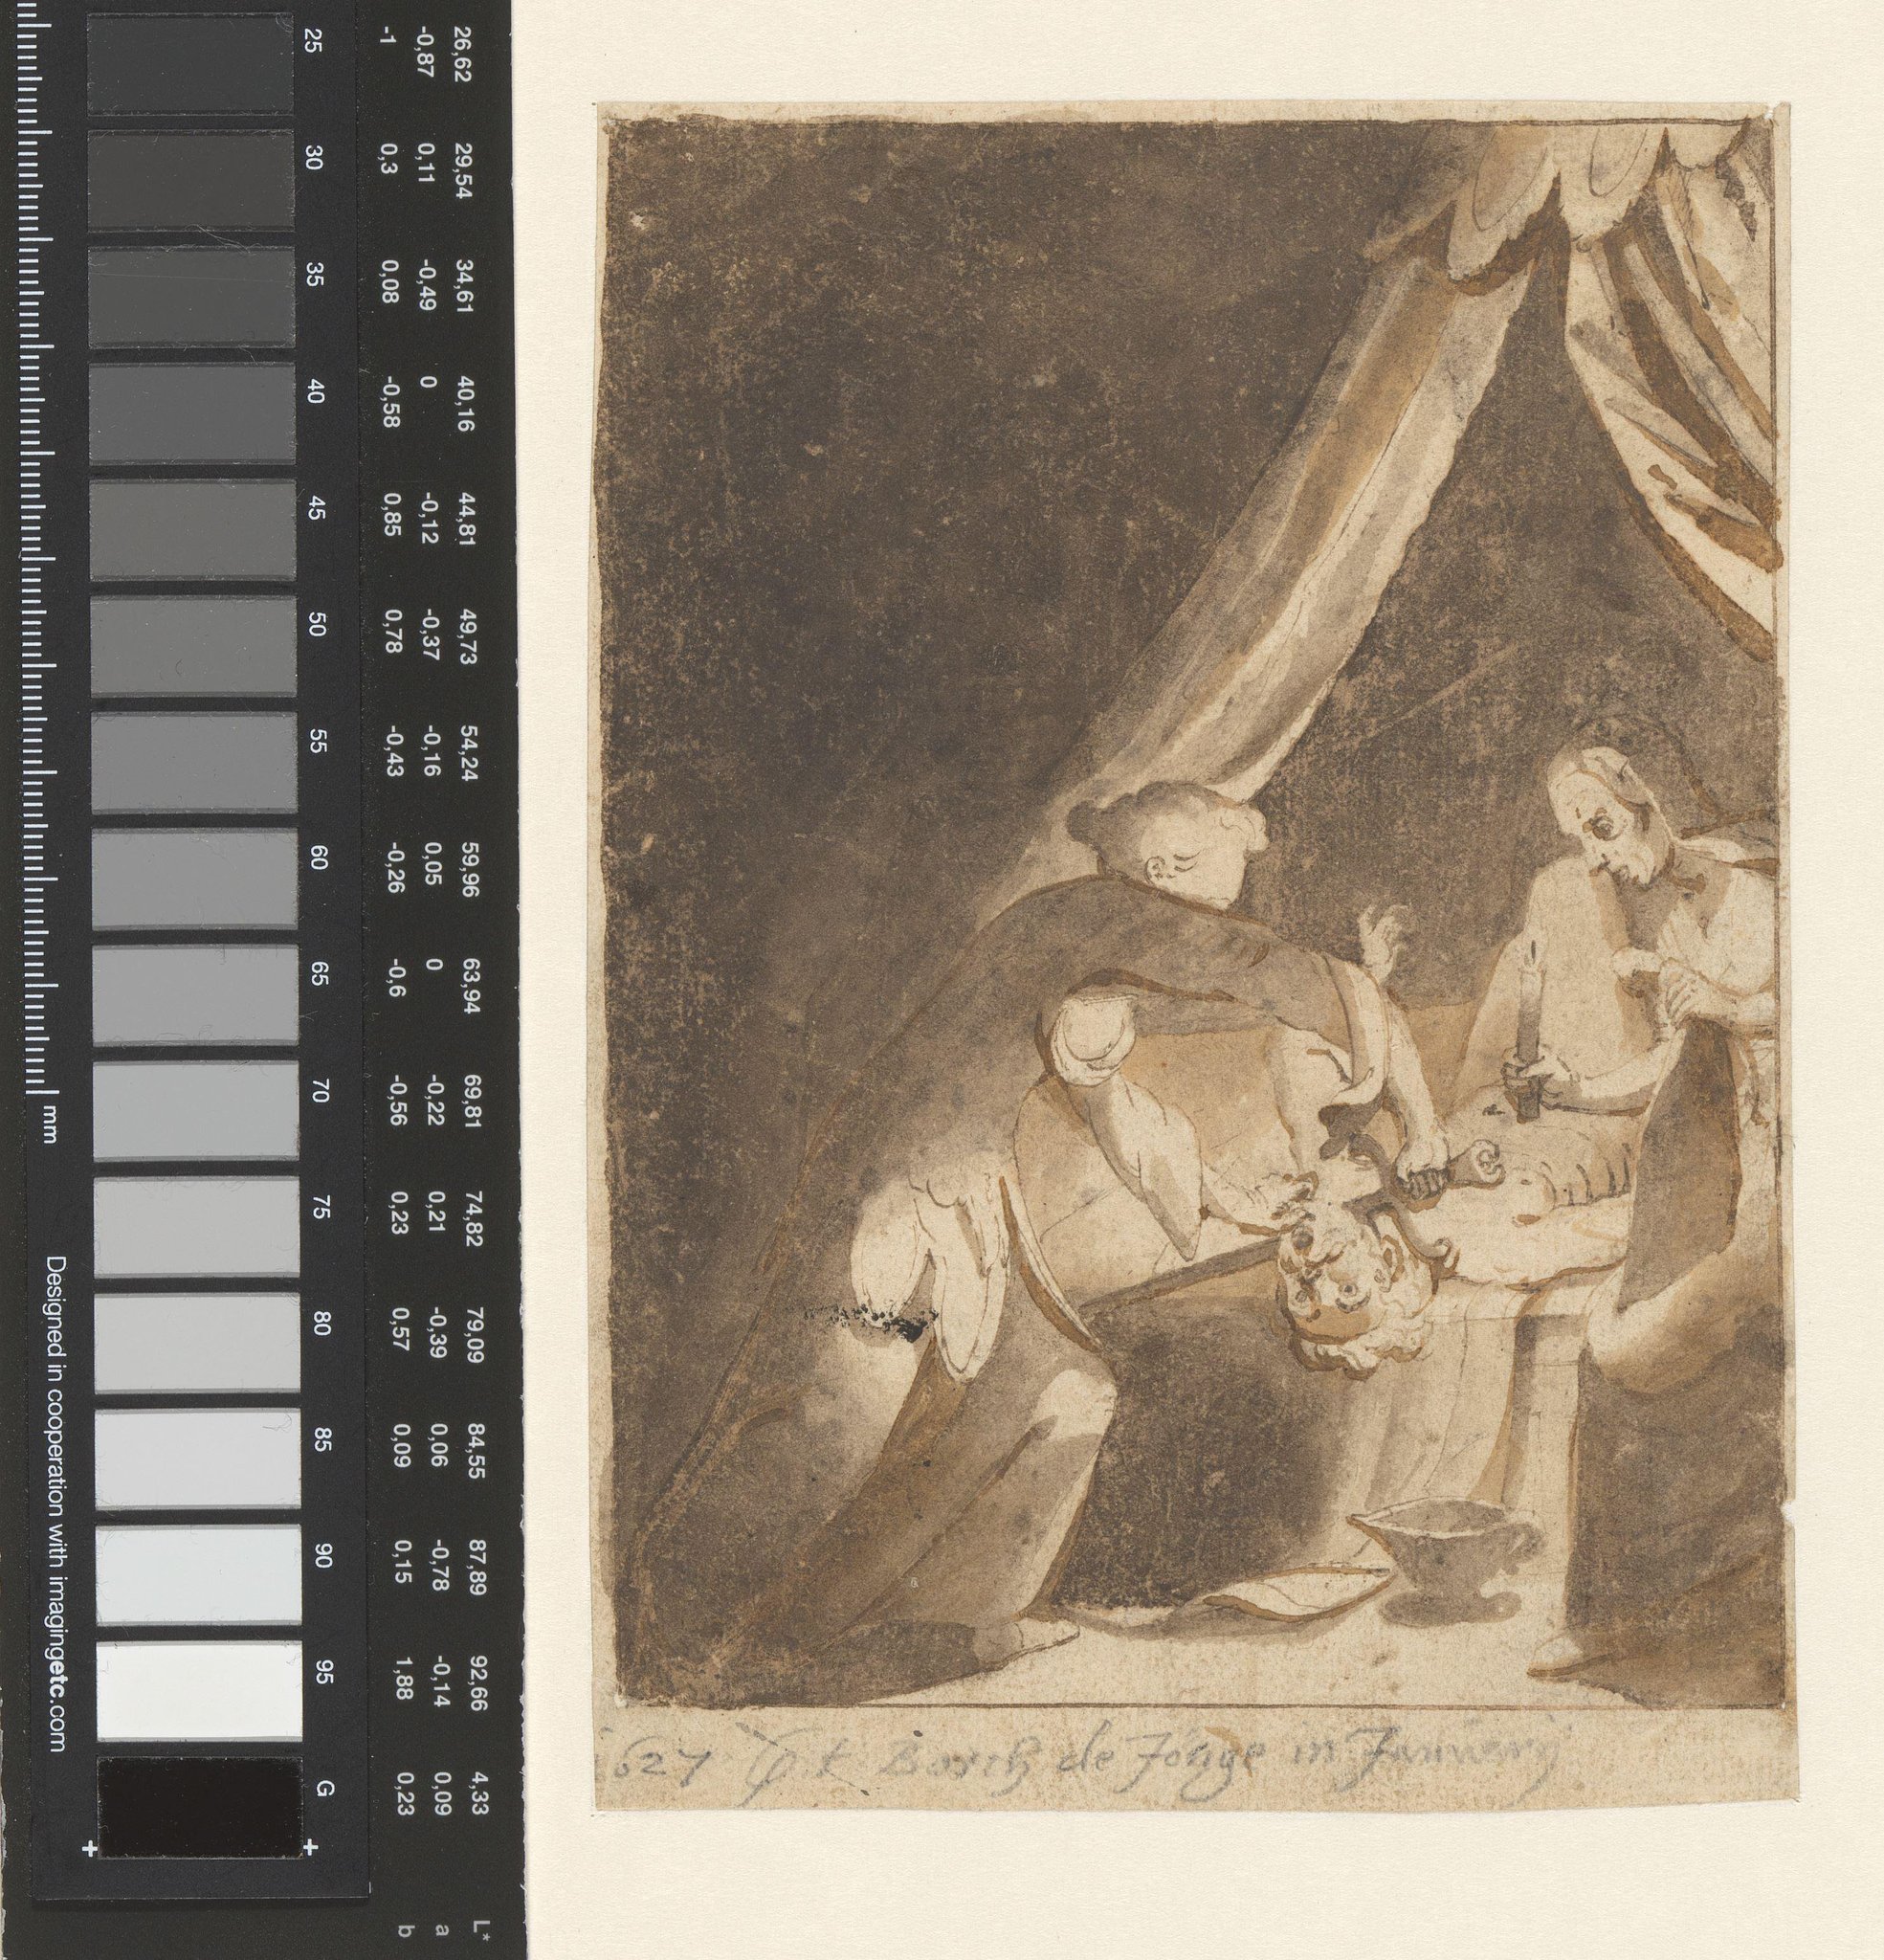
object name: drawing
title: Judith en Holofernes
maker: gerard ter borch (ii)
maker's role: draughtsman, painter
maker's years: 1617-1681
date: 1601-1627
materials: ink, paper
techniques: brush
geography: zwolle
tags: judith and holofernes (judith 8-16)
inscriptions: signature and date: ‘1627 G.t Borch de Jonge in Januarij’, annotation: ‘G. Ter Borch’